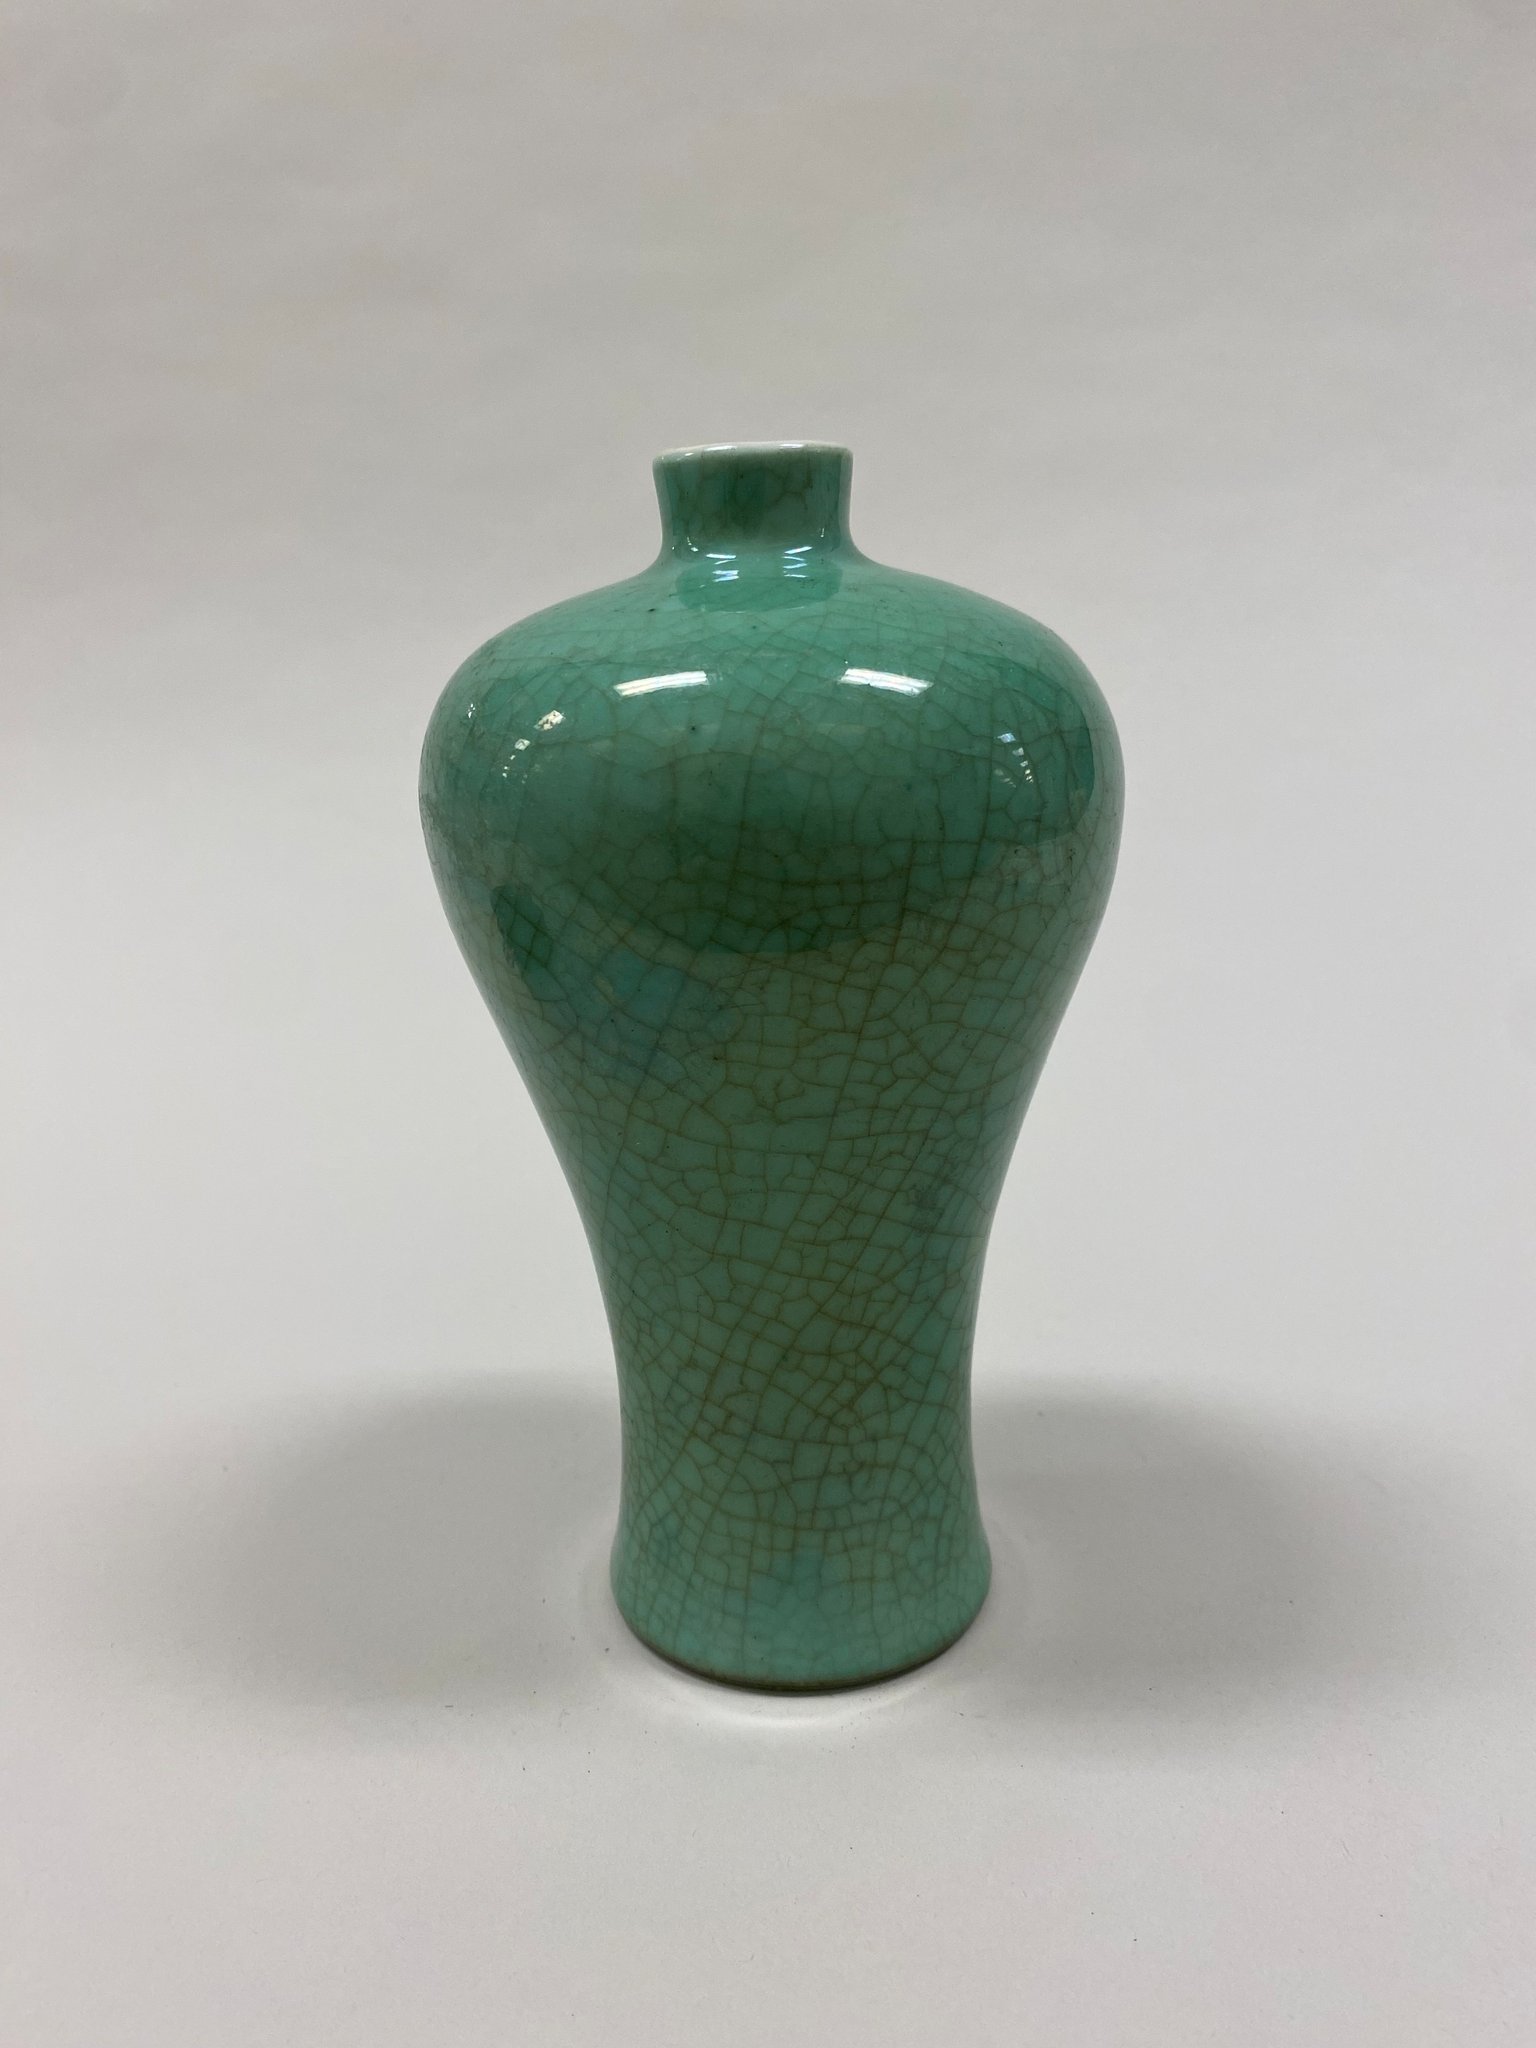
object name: vase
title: Meiping vase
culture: chinese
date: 1701-1733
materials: glaze, porcelain